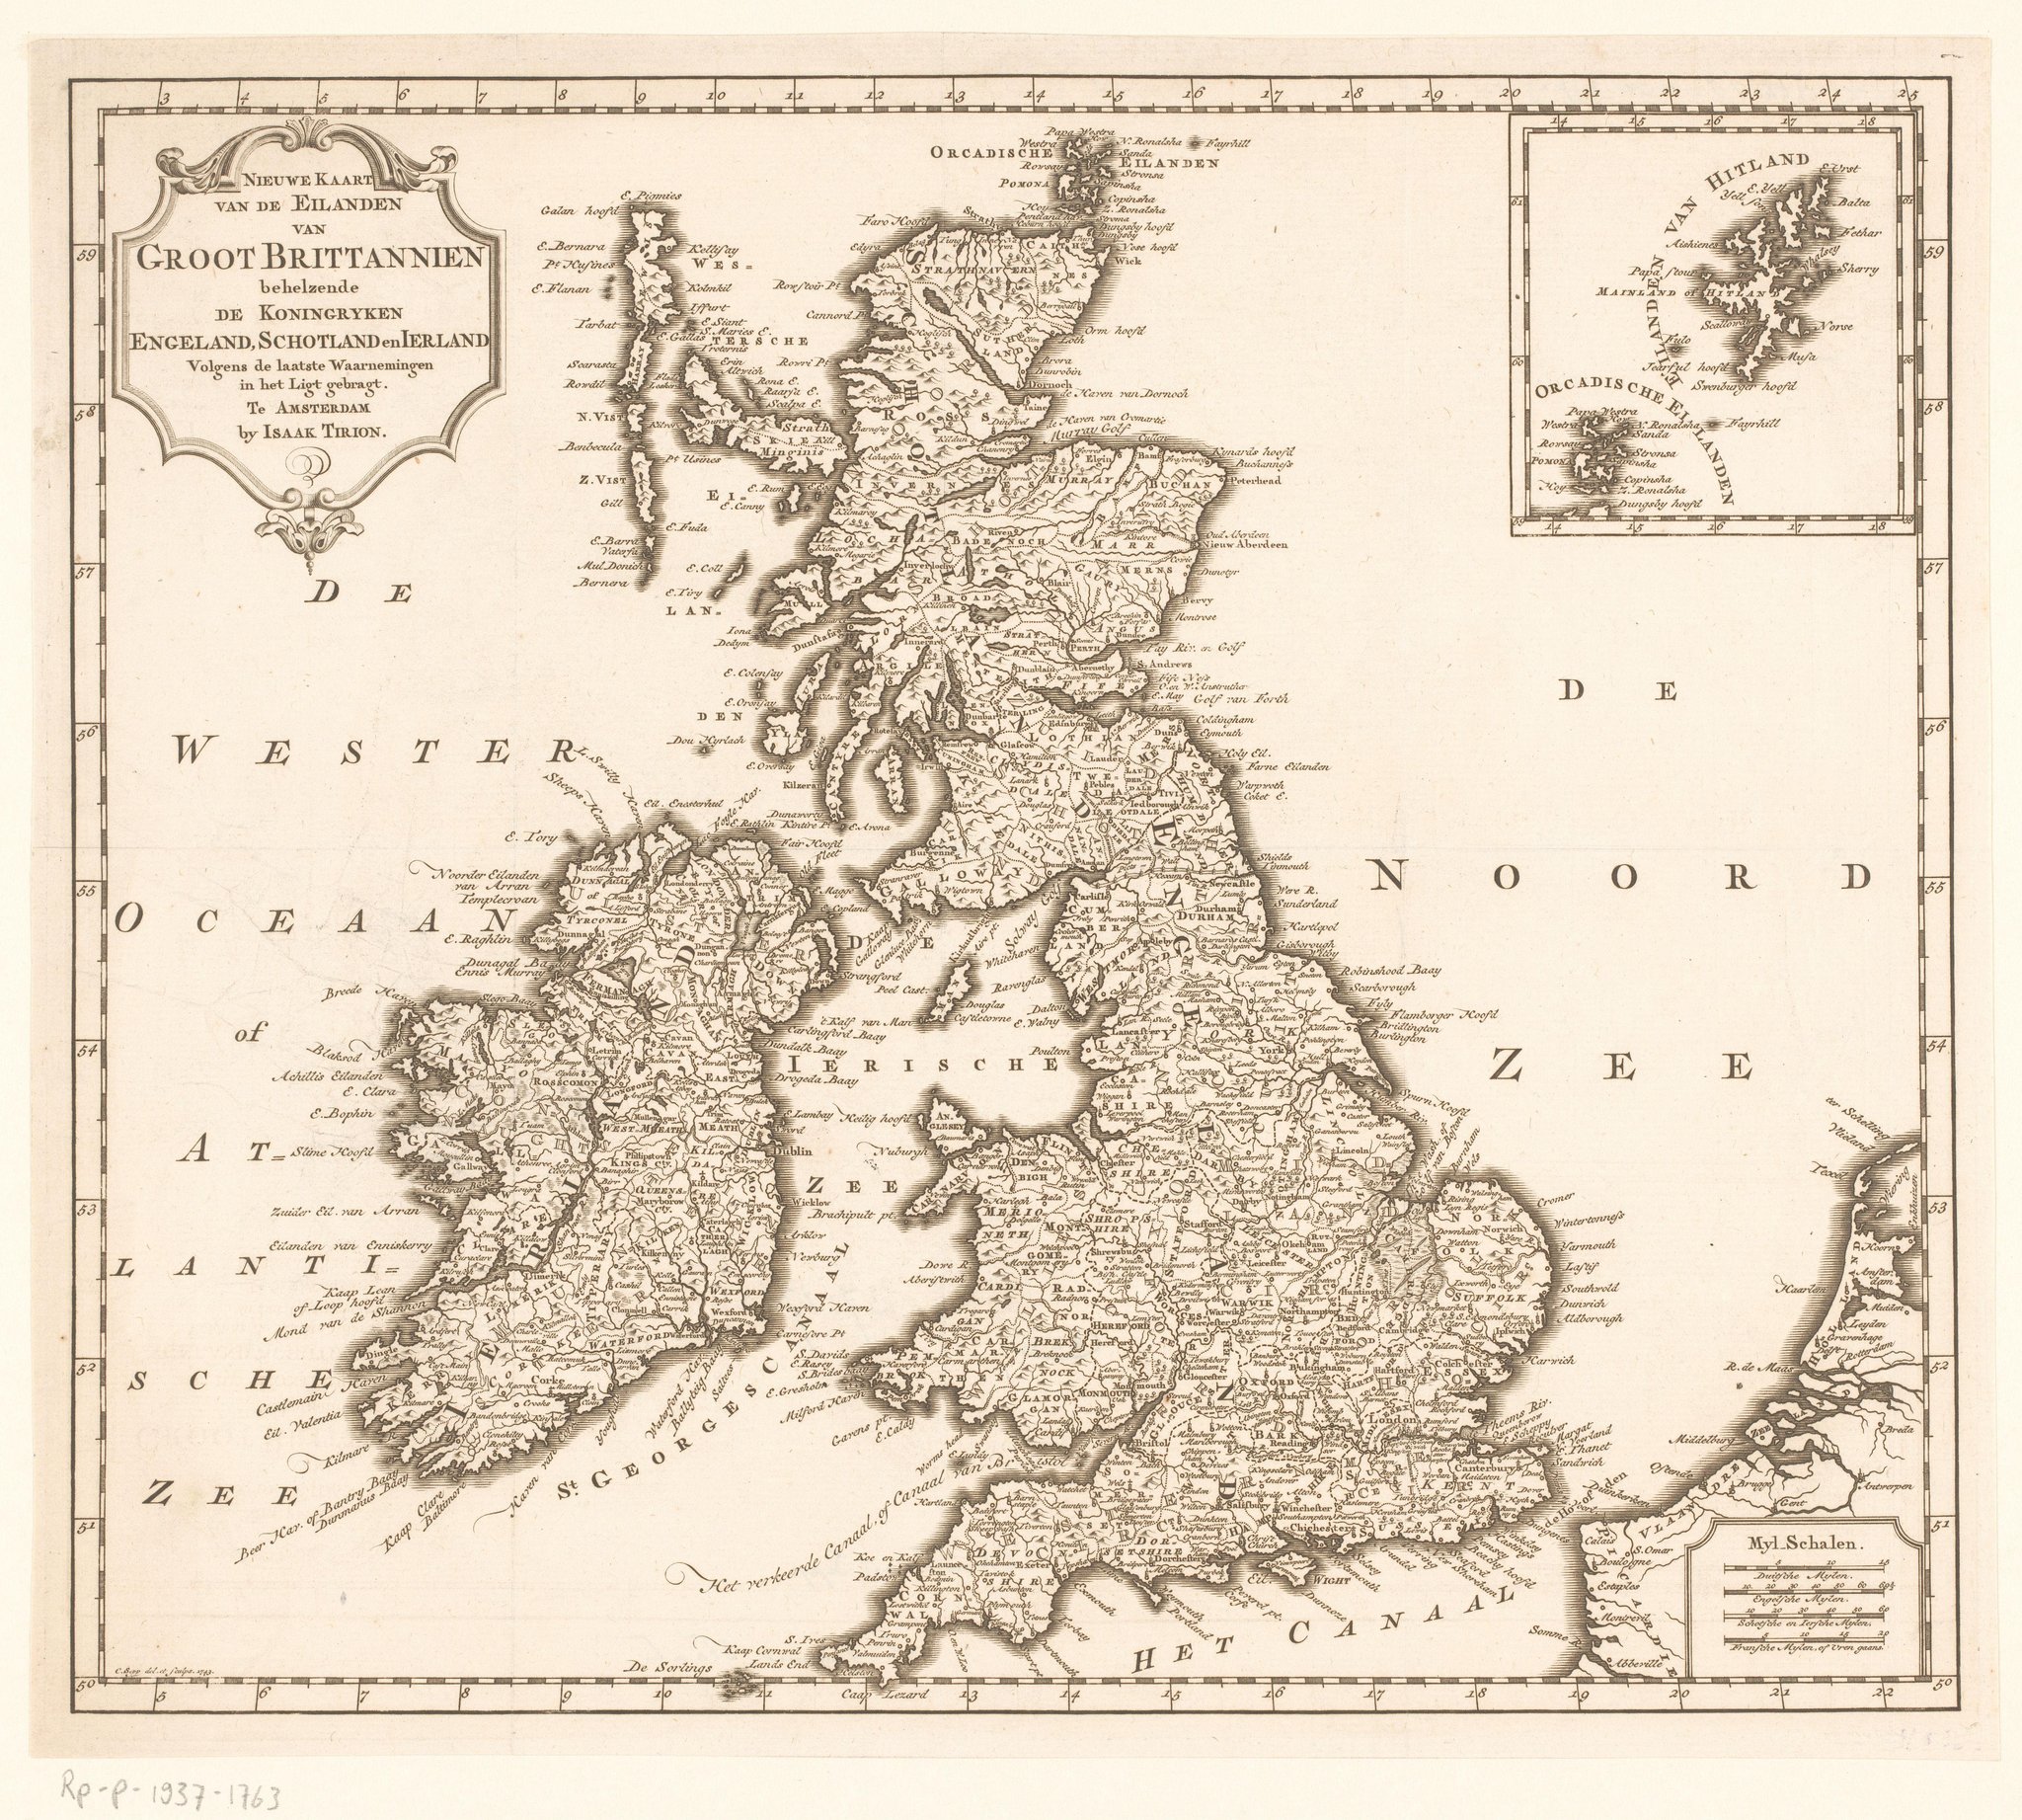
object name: map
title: Kaart van Groot-Brittannië en Ierland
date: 1743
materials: paper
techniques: engraving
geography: amsterdam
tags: maps of separate countries or regions, great britain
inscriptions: collector's mark: Lugt 2760, collector's mark: Lugt 2228